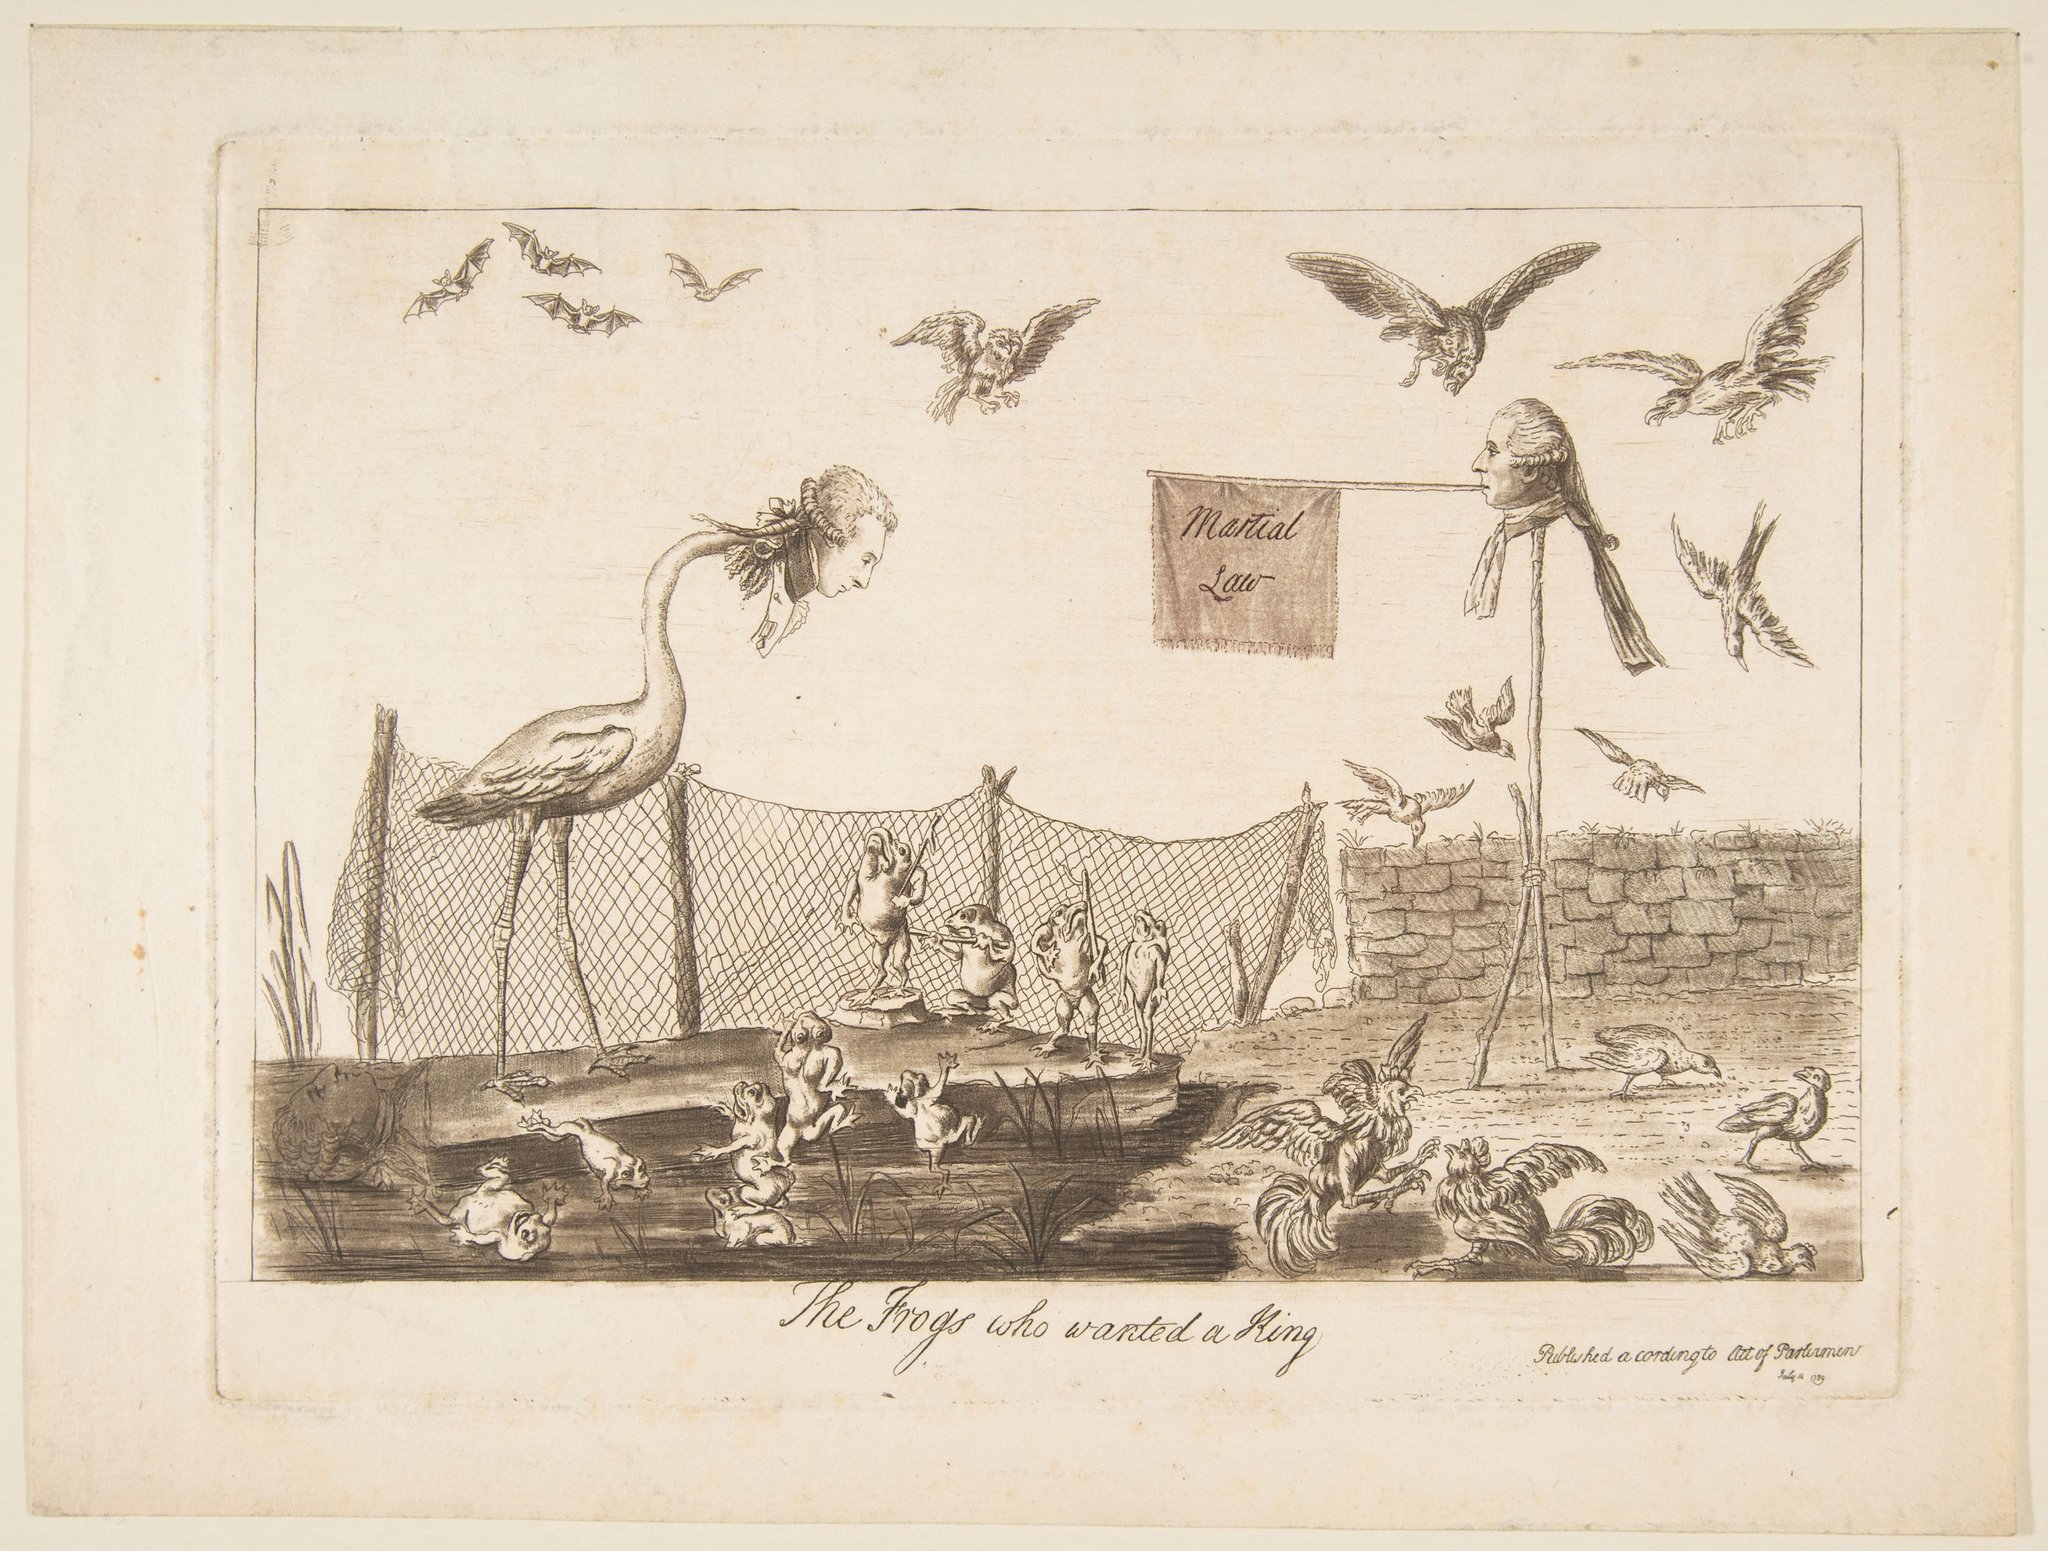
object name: print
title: The Frogs Who Wanted a King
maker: anonymous, british, 18th century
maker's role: artist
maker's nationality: british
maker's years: 1700-1800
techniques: aquatint, etching, roulette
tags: bats,birds,satire,french revolution,frogs,politics